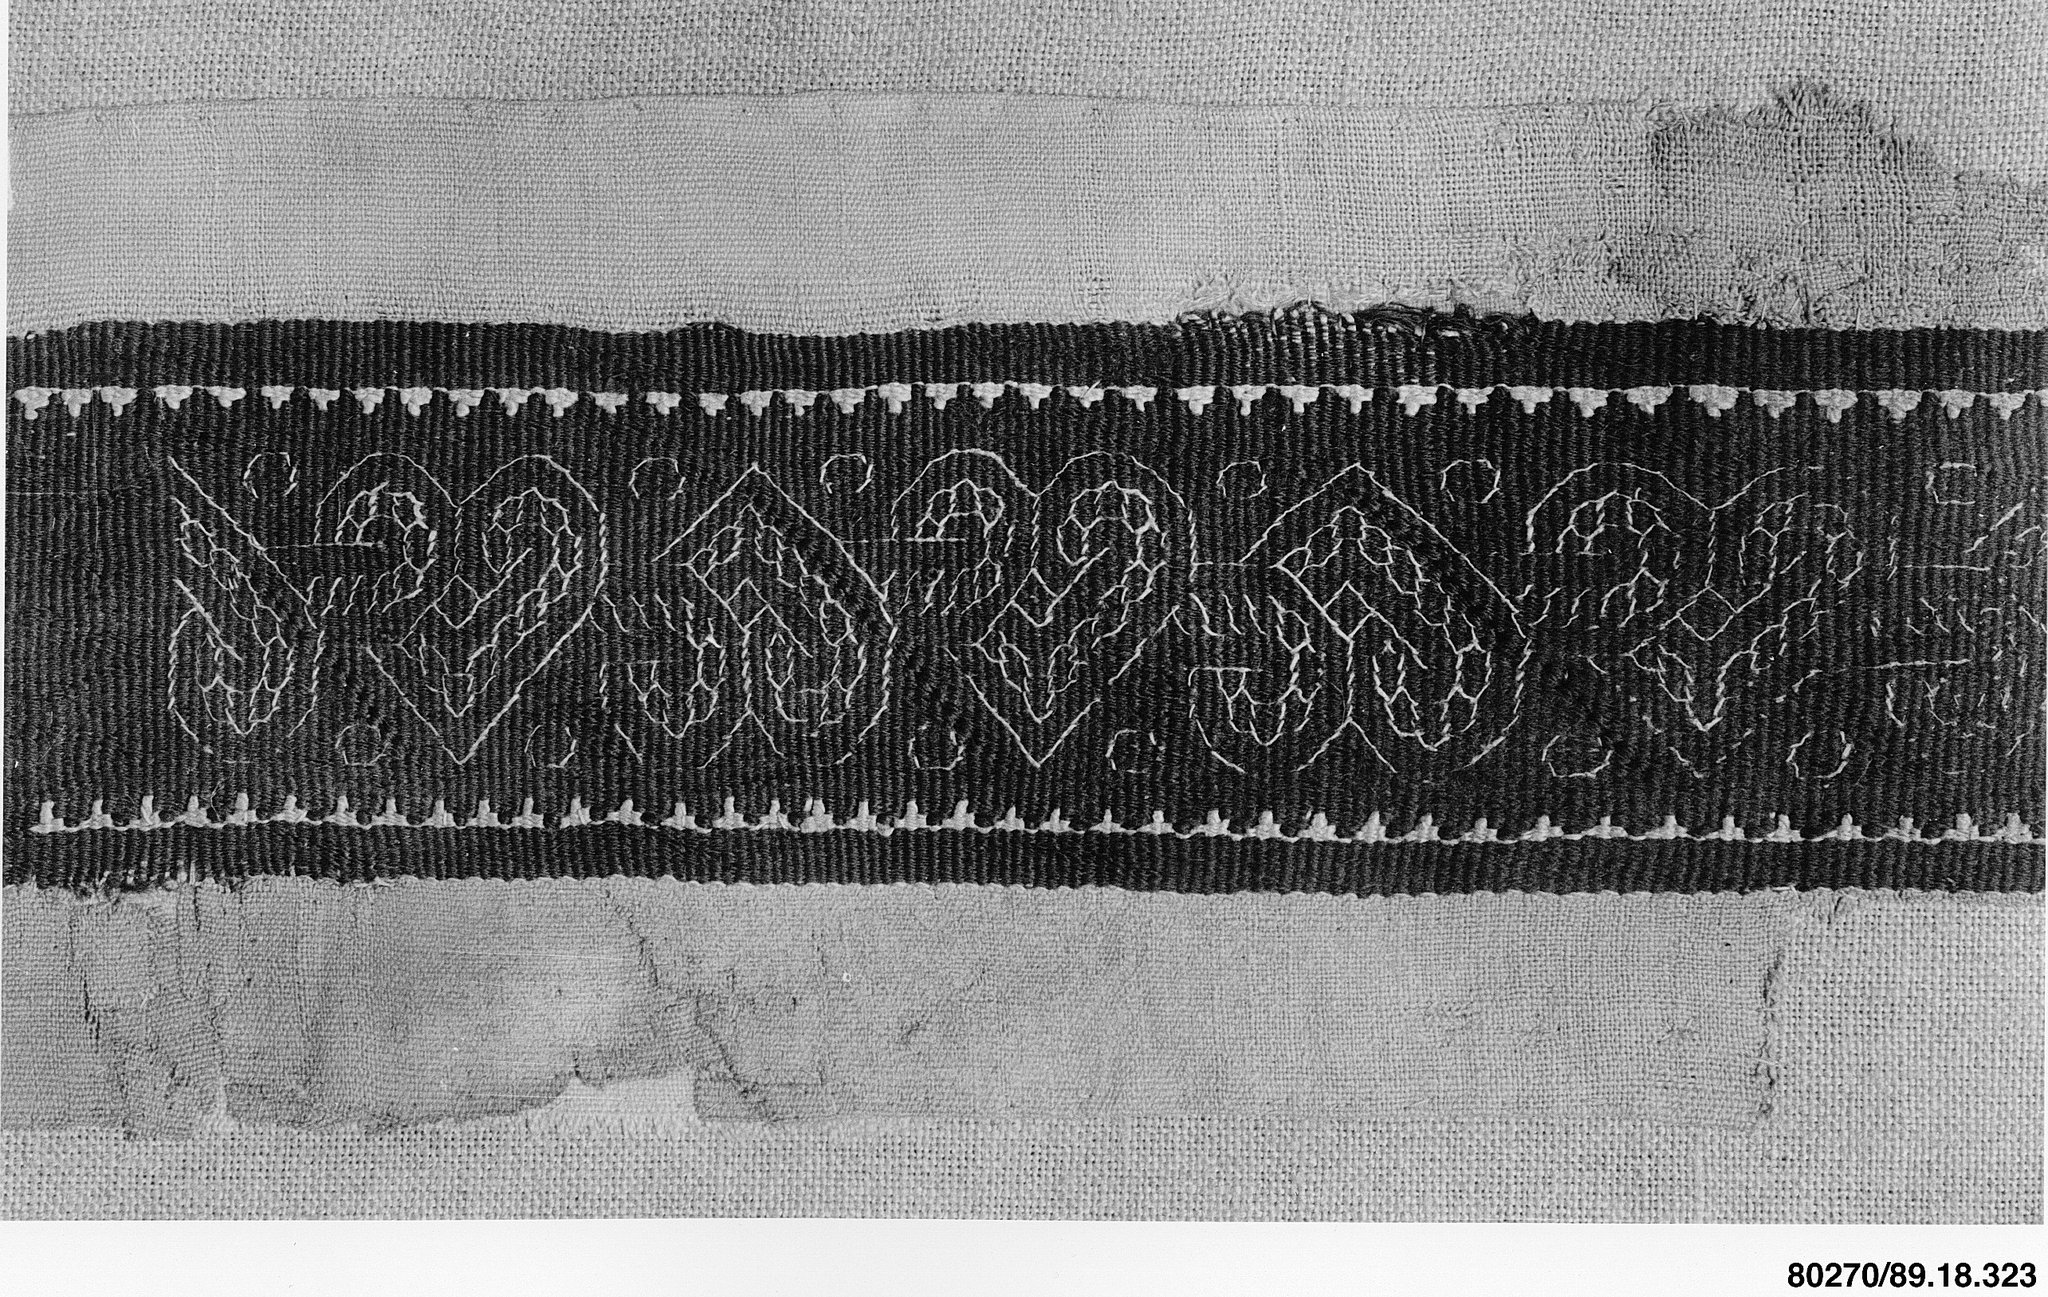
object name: textile fragment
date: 201-400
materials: linen, wool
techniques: weave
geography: egypt